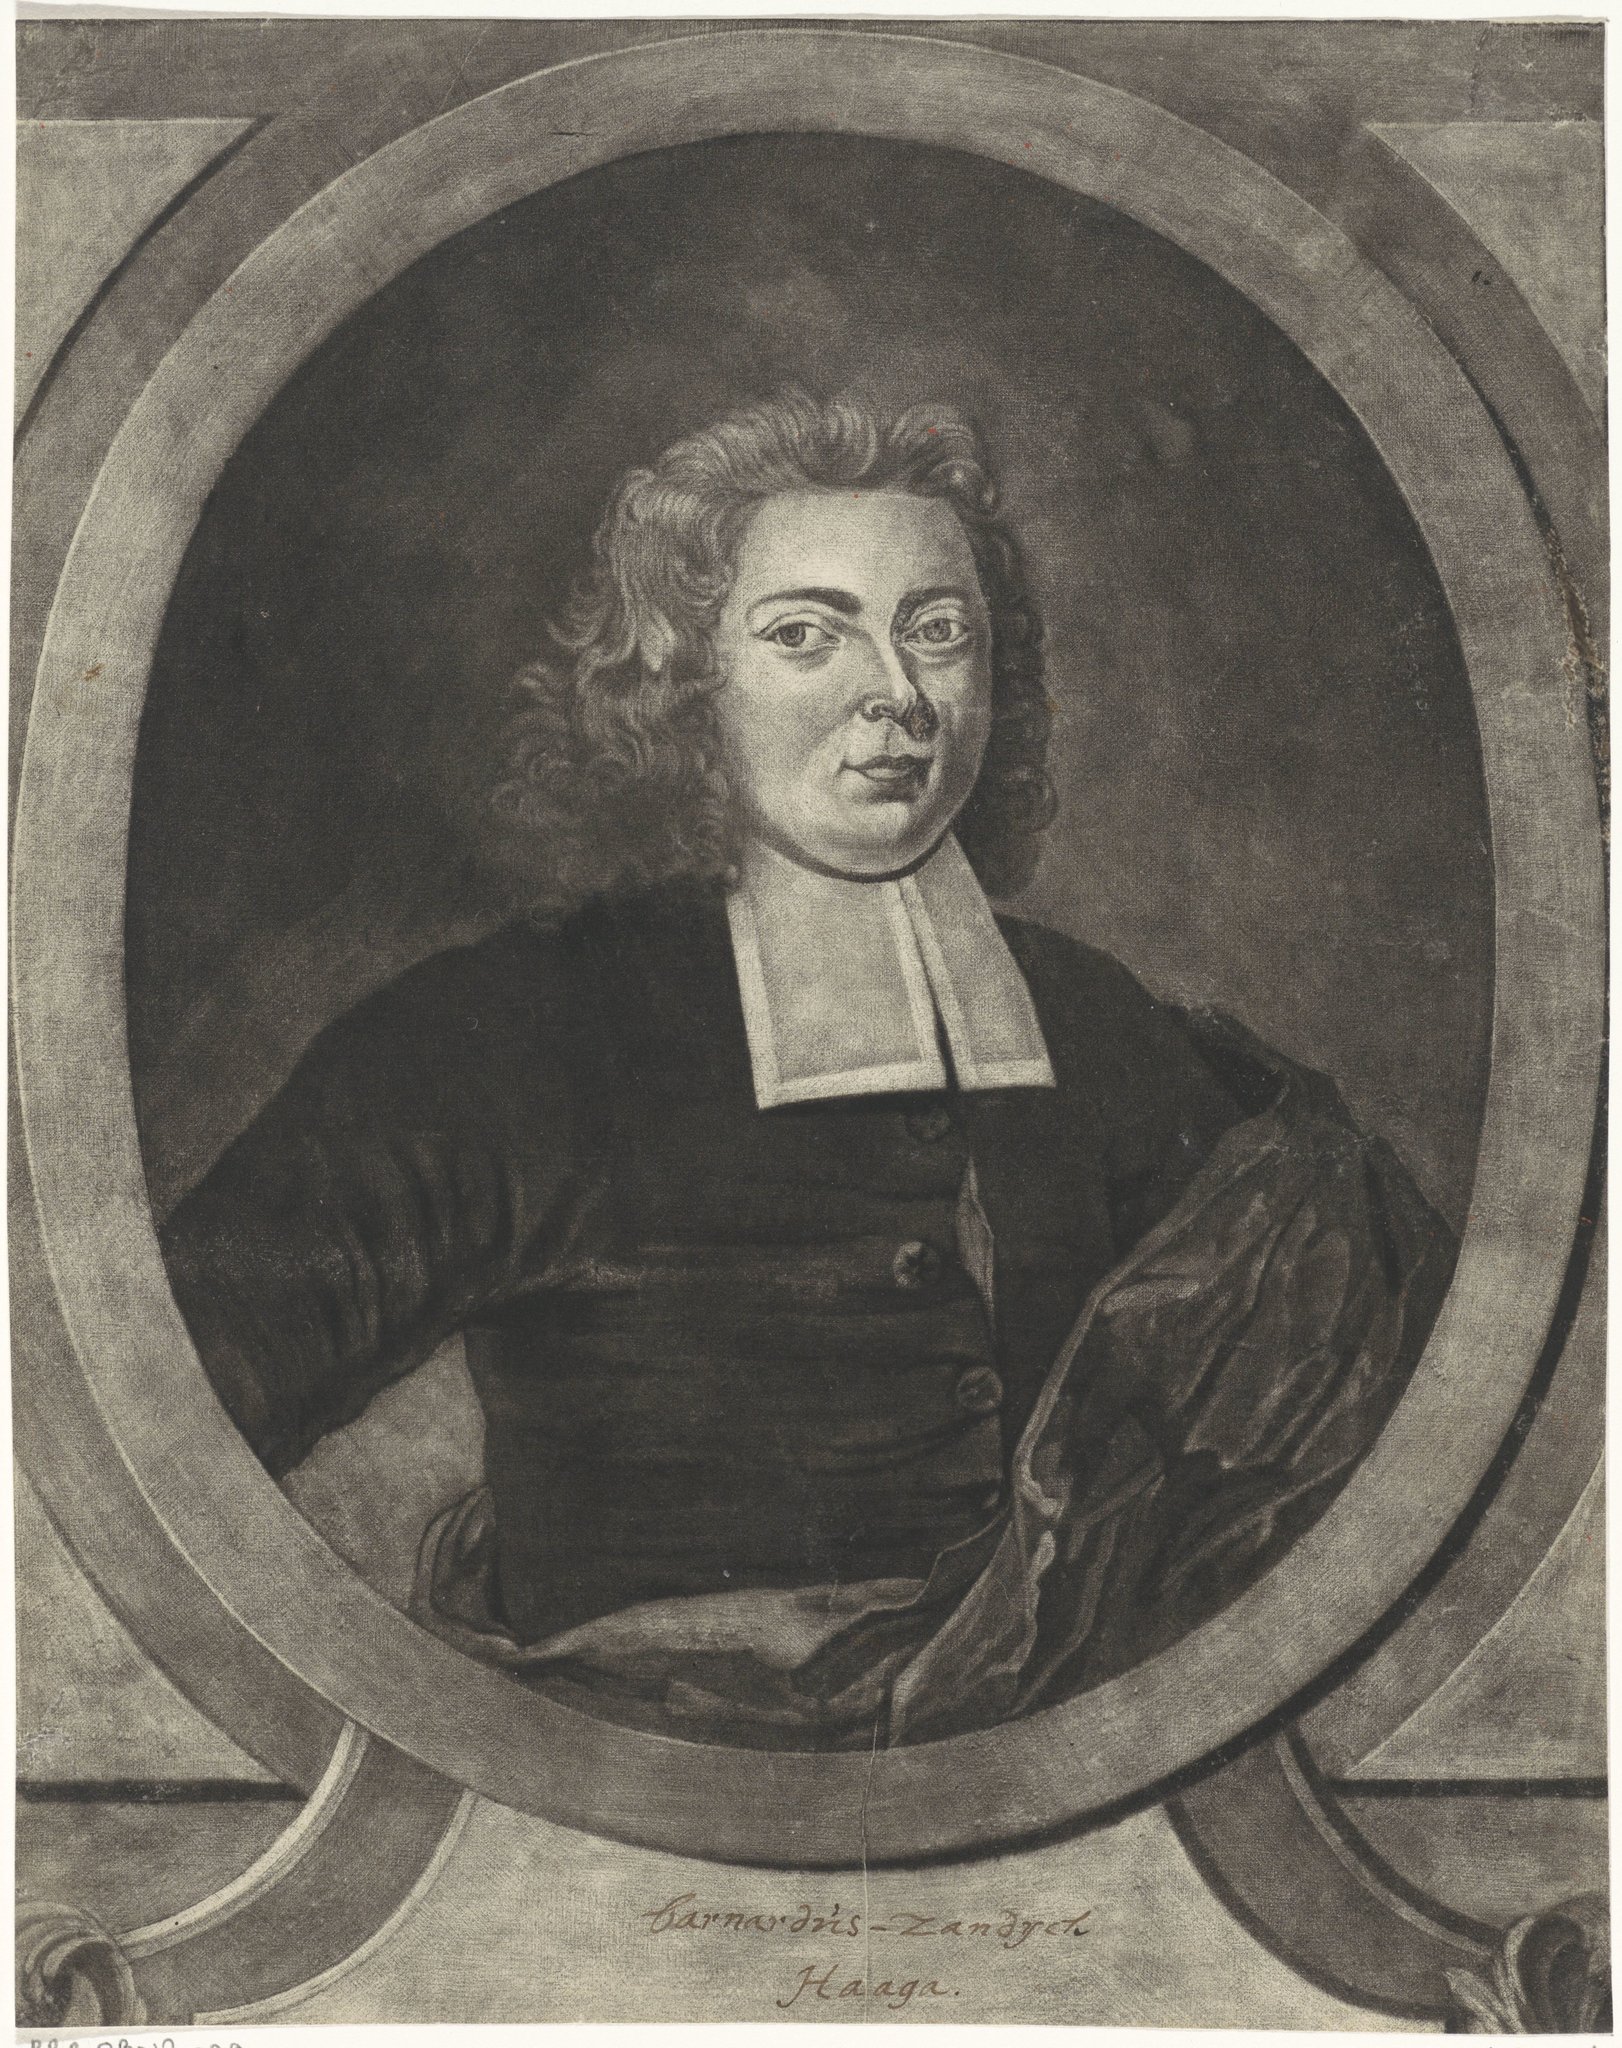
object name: print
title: Portret van Bernardus Sandijk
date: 1709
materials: paper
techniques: mezzotint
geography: amsterdam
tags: the hague, theologian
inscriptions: collector's mark: Lugt 964, inscription: ‘Barnardis - Zandyck / Haaga.’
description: De predikant Bernardus Sandijk op 28-jarige leeftijd.